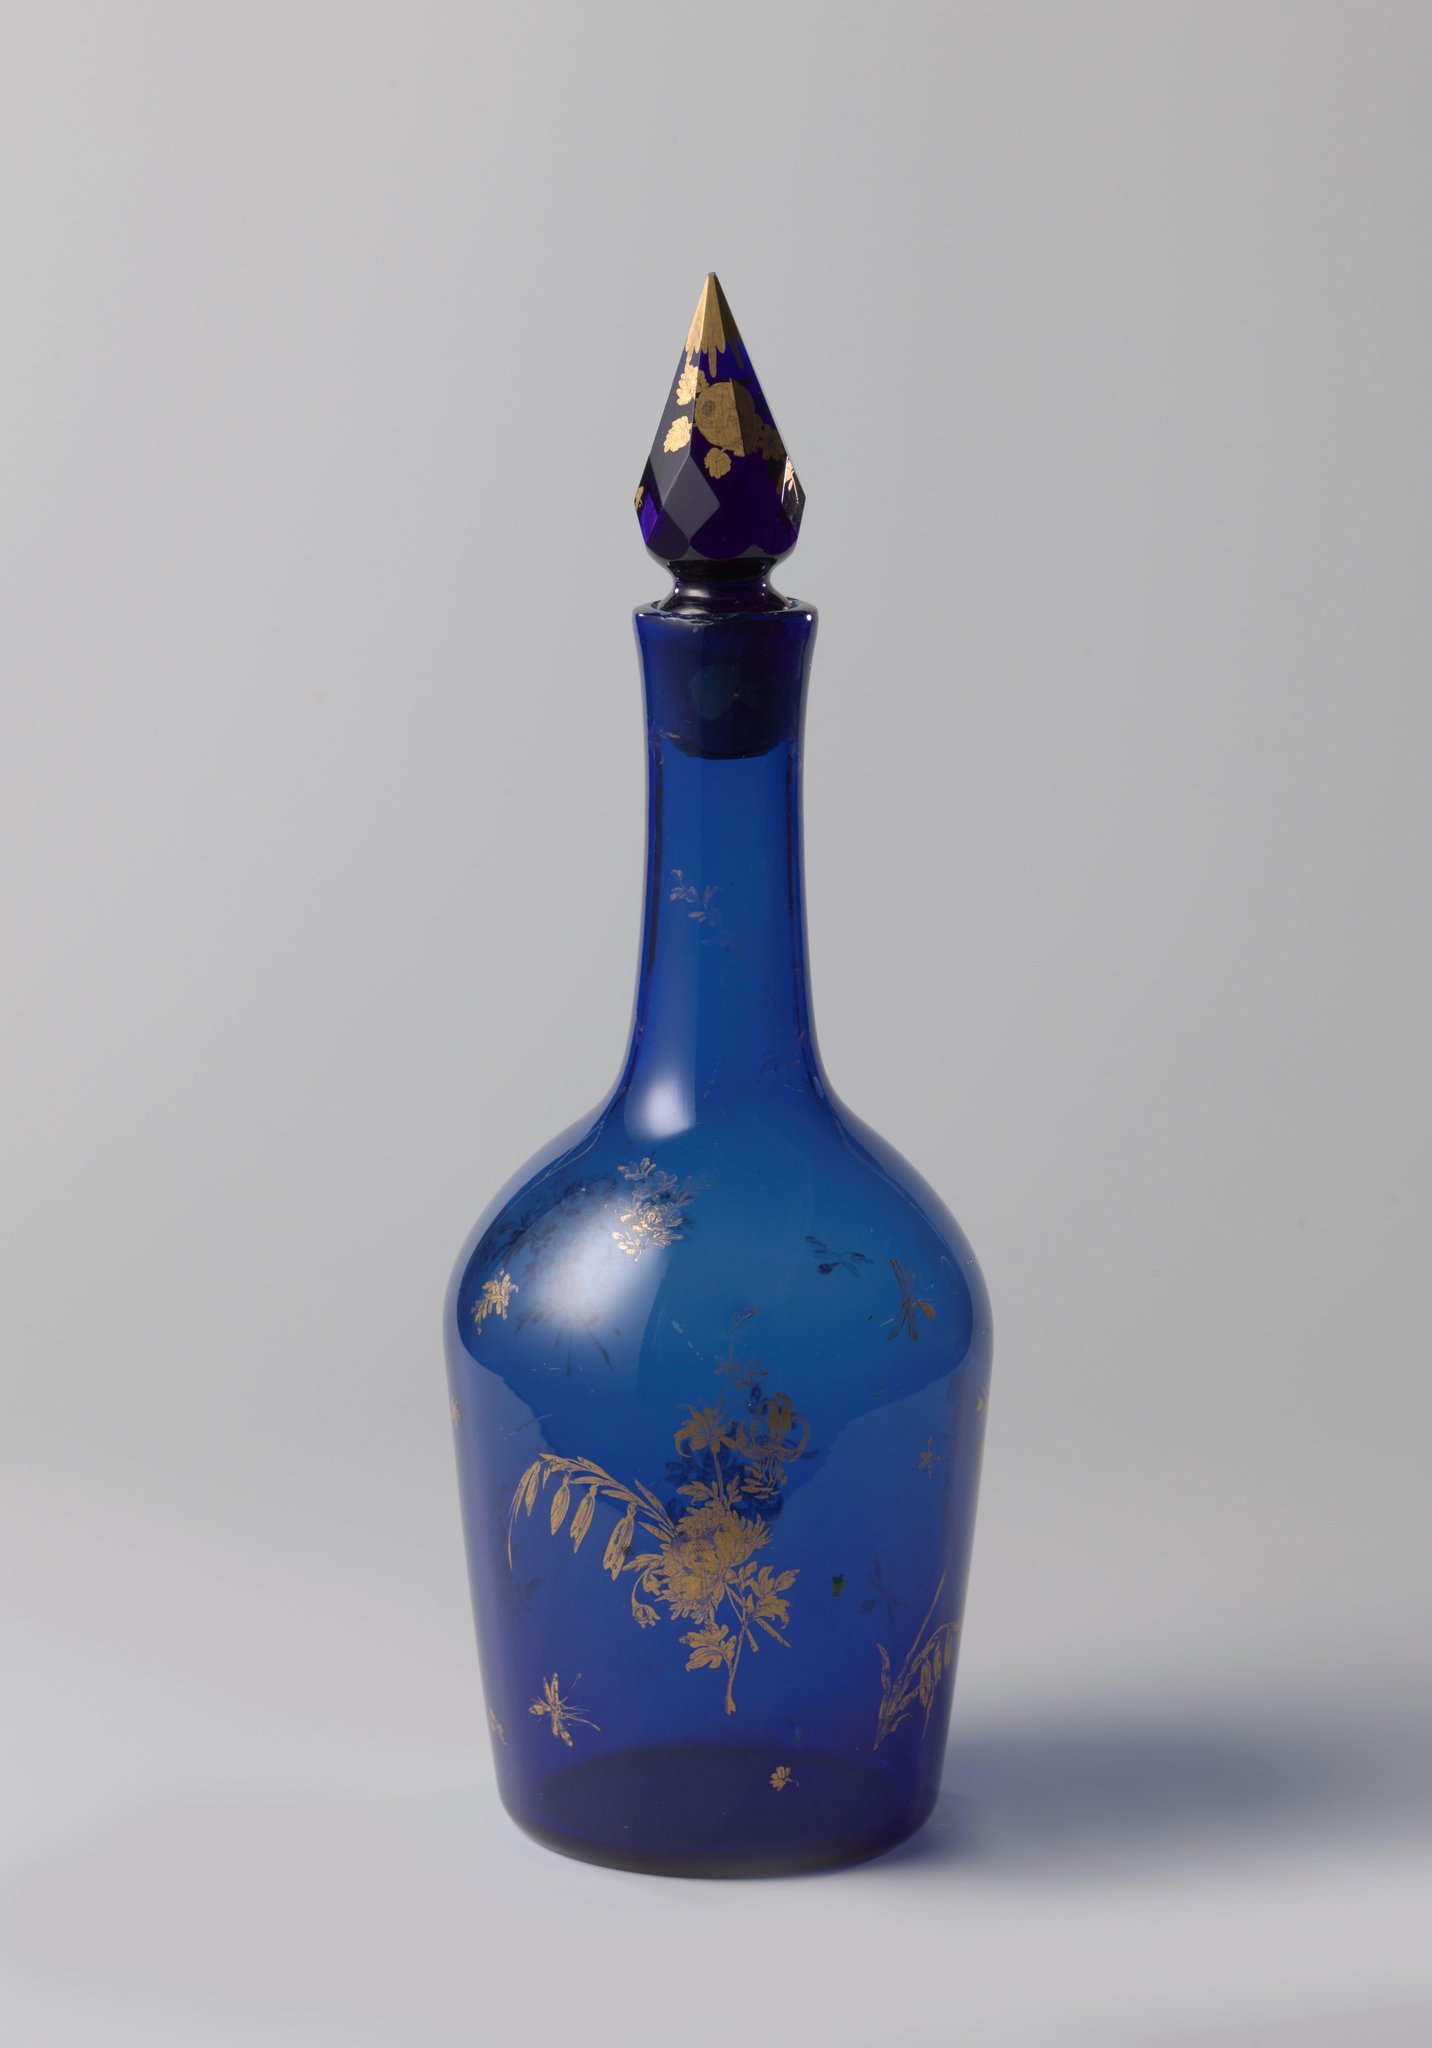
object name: carafe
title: Karaf, met boeketten, insekten en strooibloemen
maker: Anonymous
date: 1765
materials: glass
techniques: gilding, glassblowing, grinding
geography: england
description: Platte geslepen bodem. Het naar boven iets uitlopende lichaam gaat via een afgeronde schouder over in een rechte hals. Op het lichaam en de hals in verguldsel boeketten, insekten en strooibloemen.